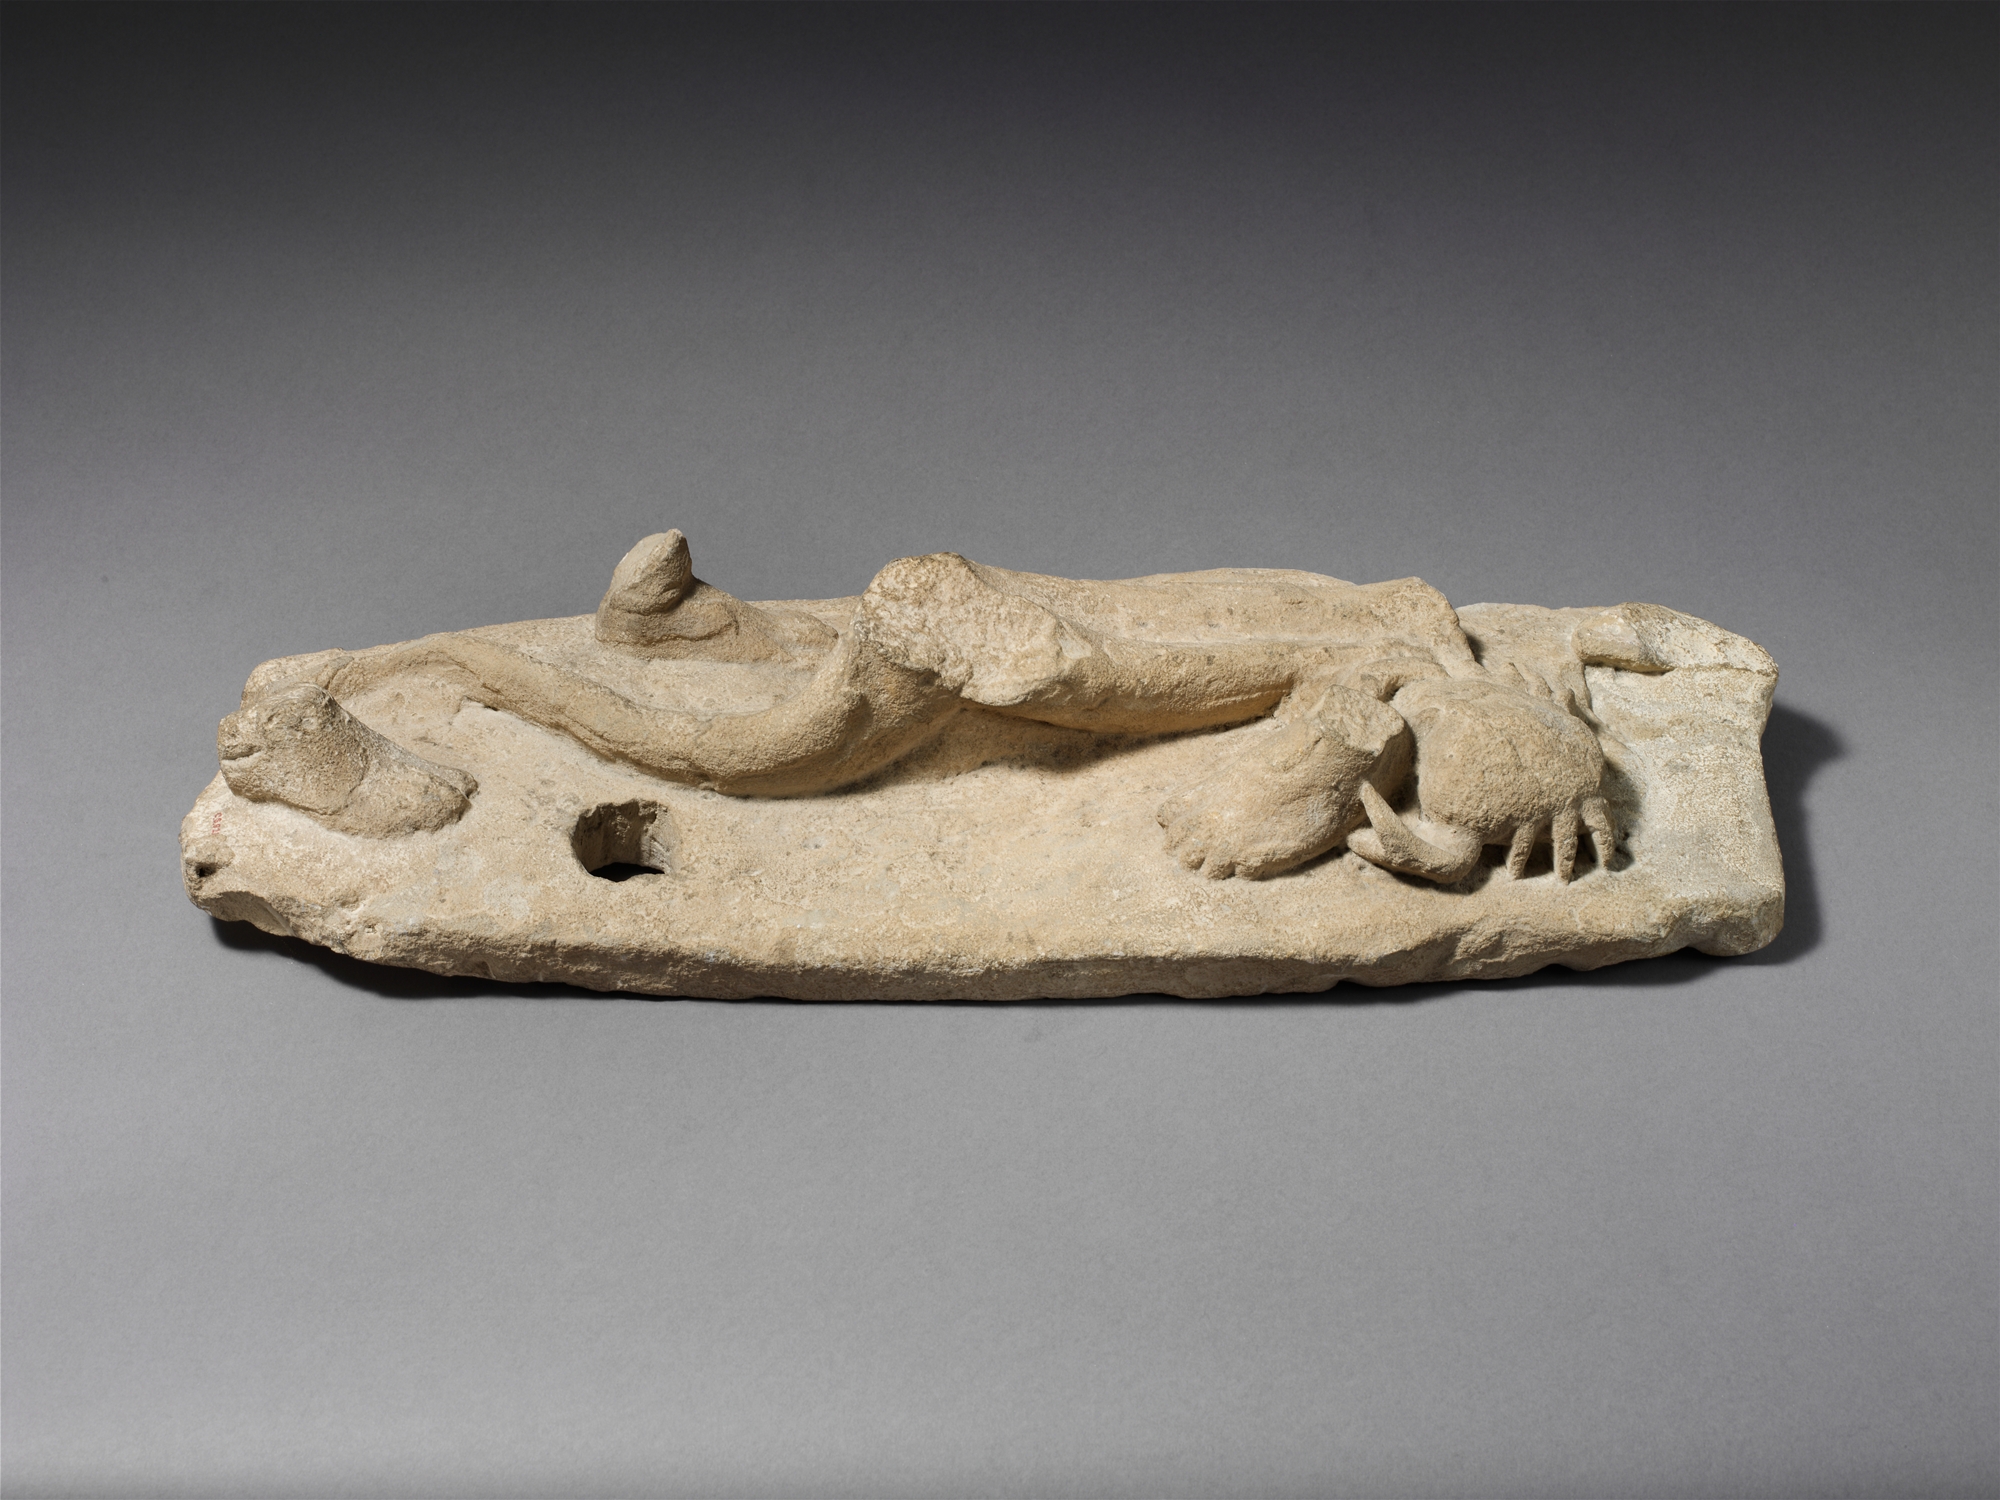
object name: statue base with herakles and hydra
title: Limestone plinth with the remains of a group of Herakles and the Hydra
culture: cypriot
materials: limestone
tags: feet